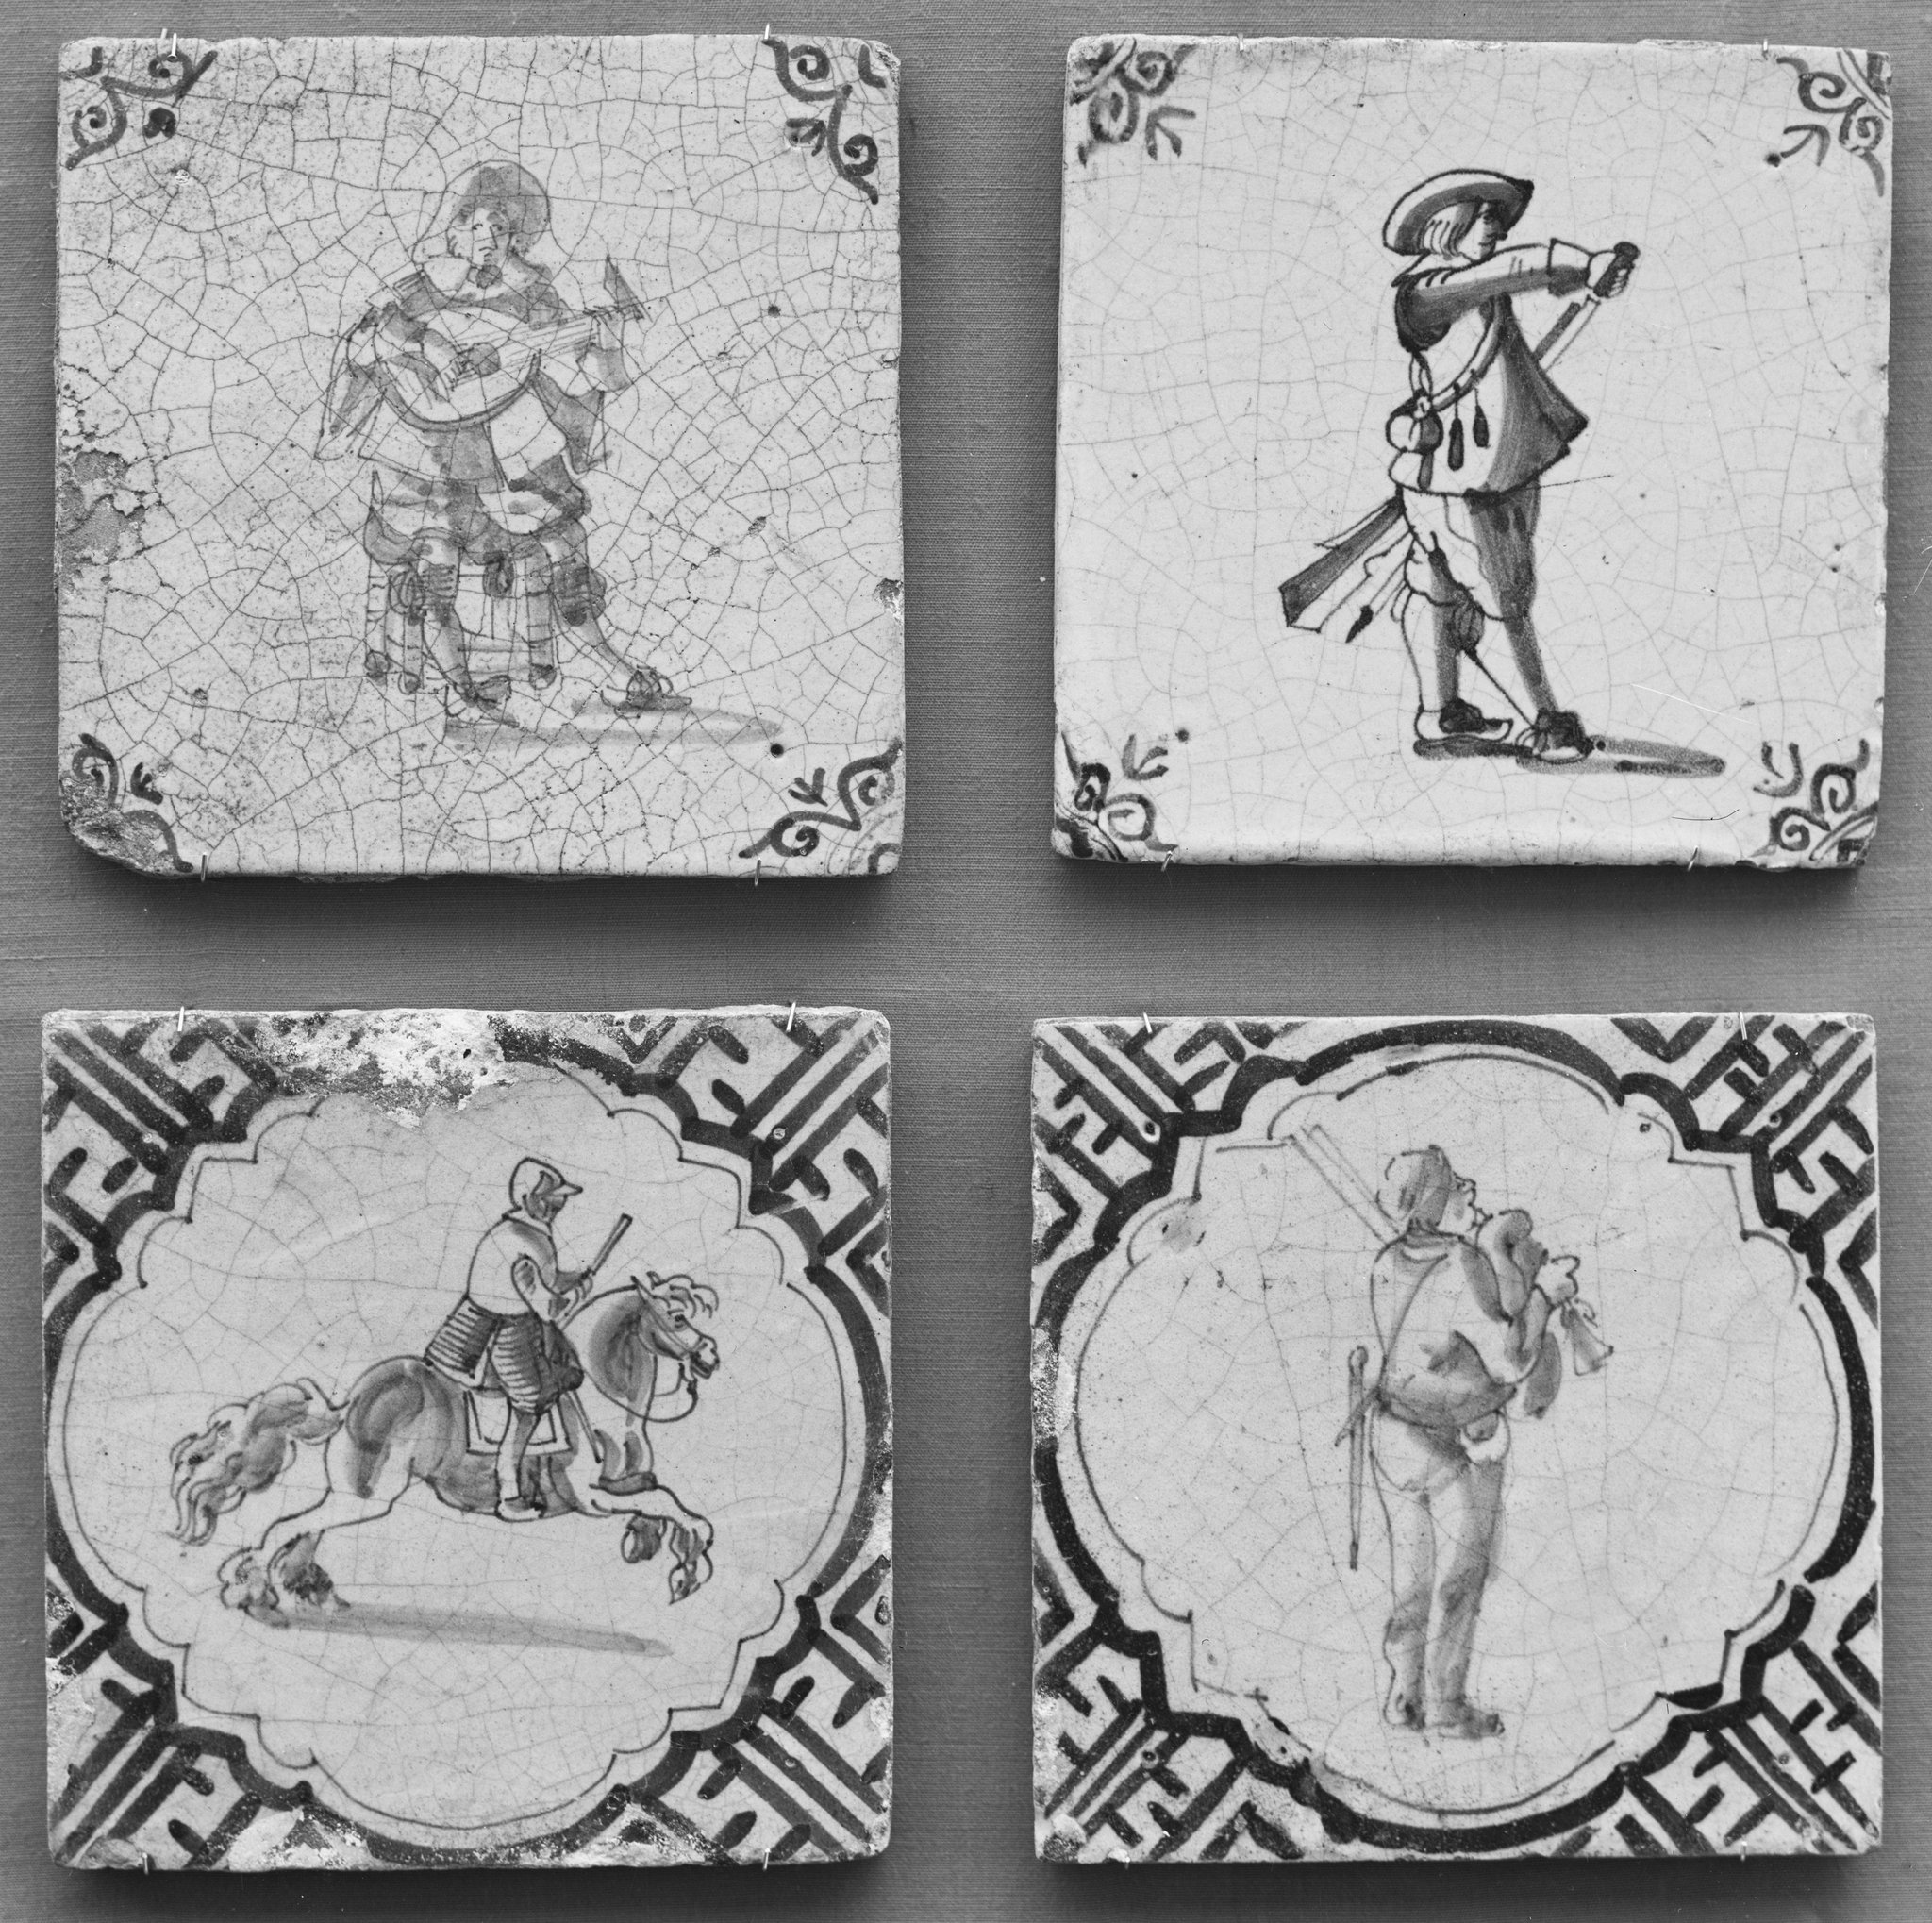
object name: tile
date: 1640-1660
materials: earthenware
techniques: glazing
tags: men,horses